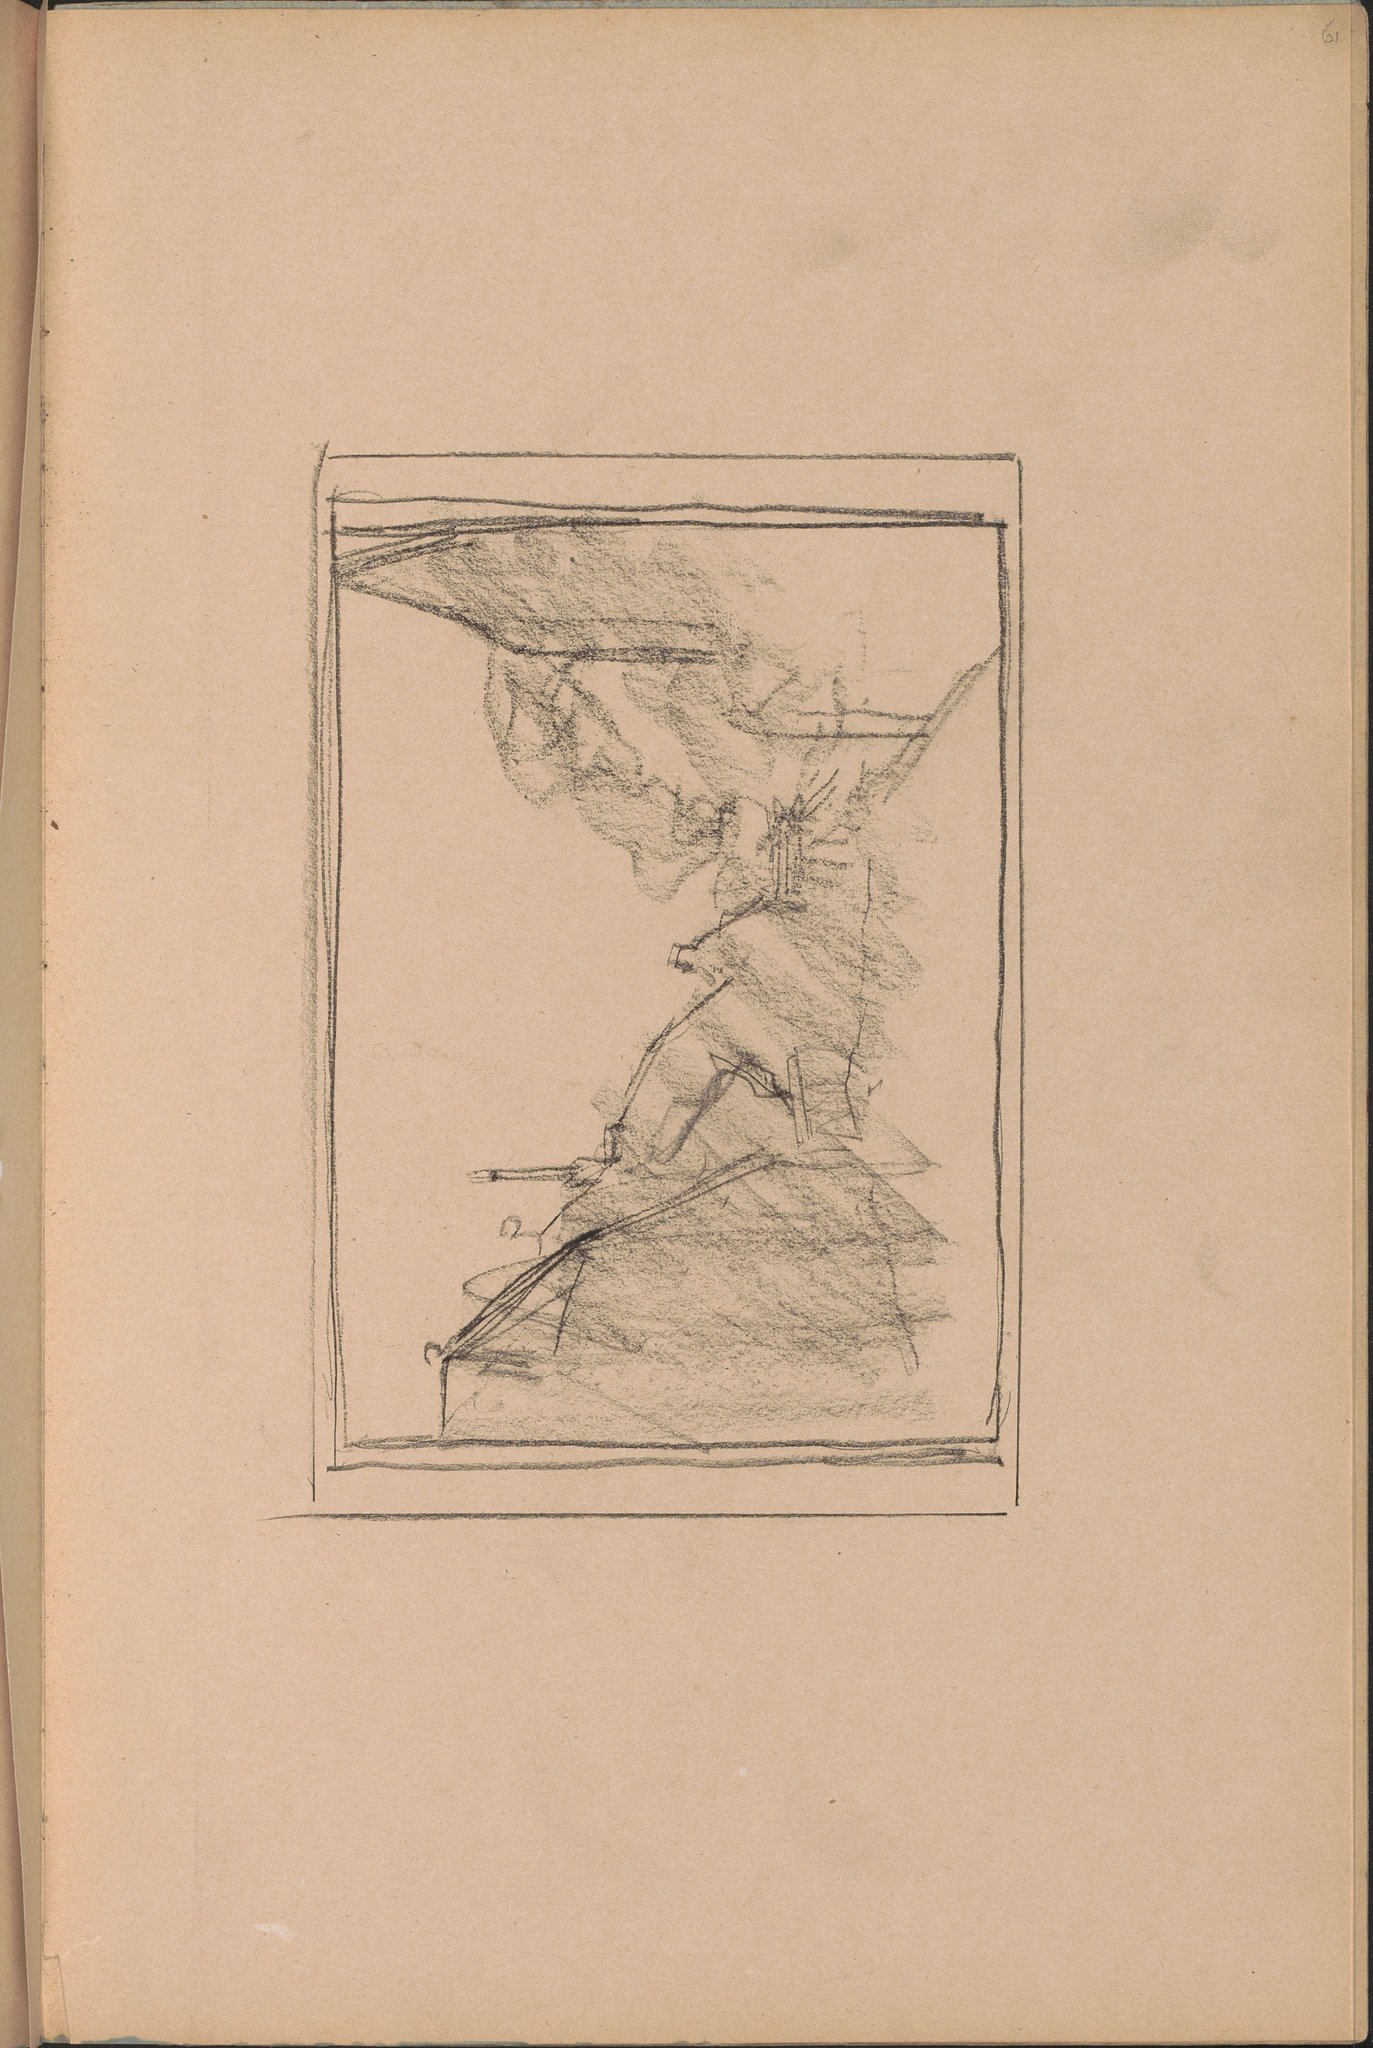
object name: sketchbook leaf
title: Dorpsstraat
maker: willem witsen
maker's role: draughtsman, painter, print maker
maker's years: 1860-1923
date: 1884-1887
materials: chalk, paper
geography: ewijkshoeve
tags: village street, farm (building)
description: Pagina 61 uit een schetsboek met 38 bladen.